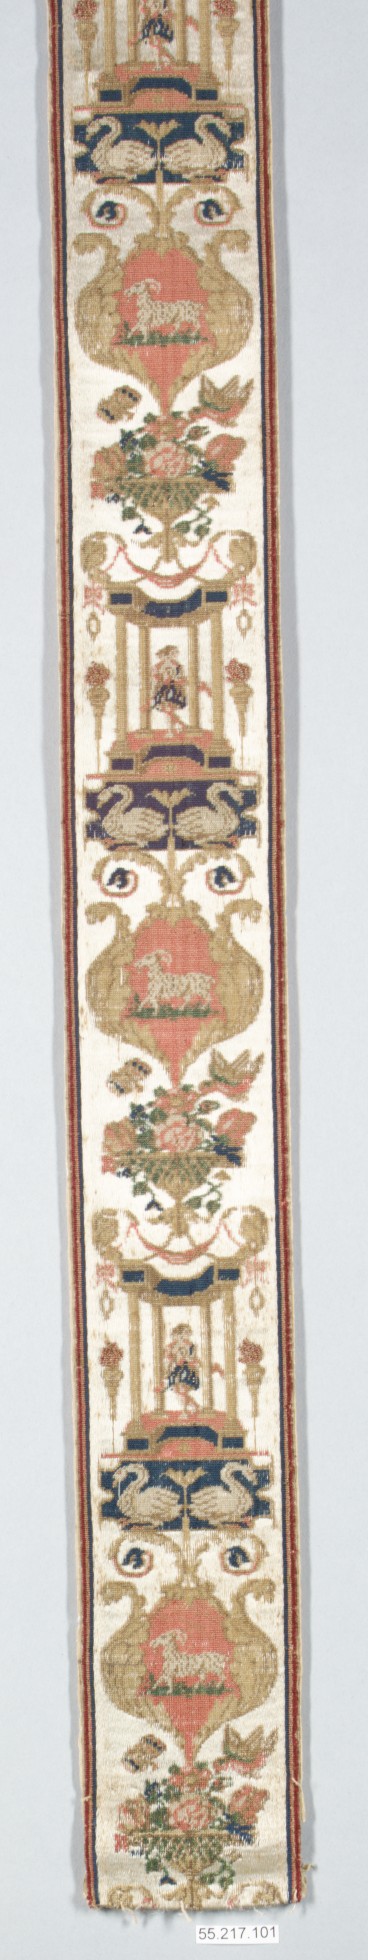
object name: piece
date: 1801-1833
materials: silk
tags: swans